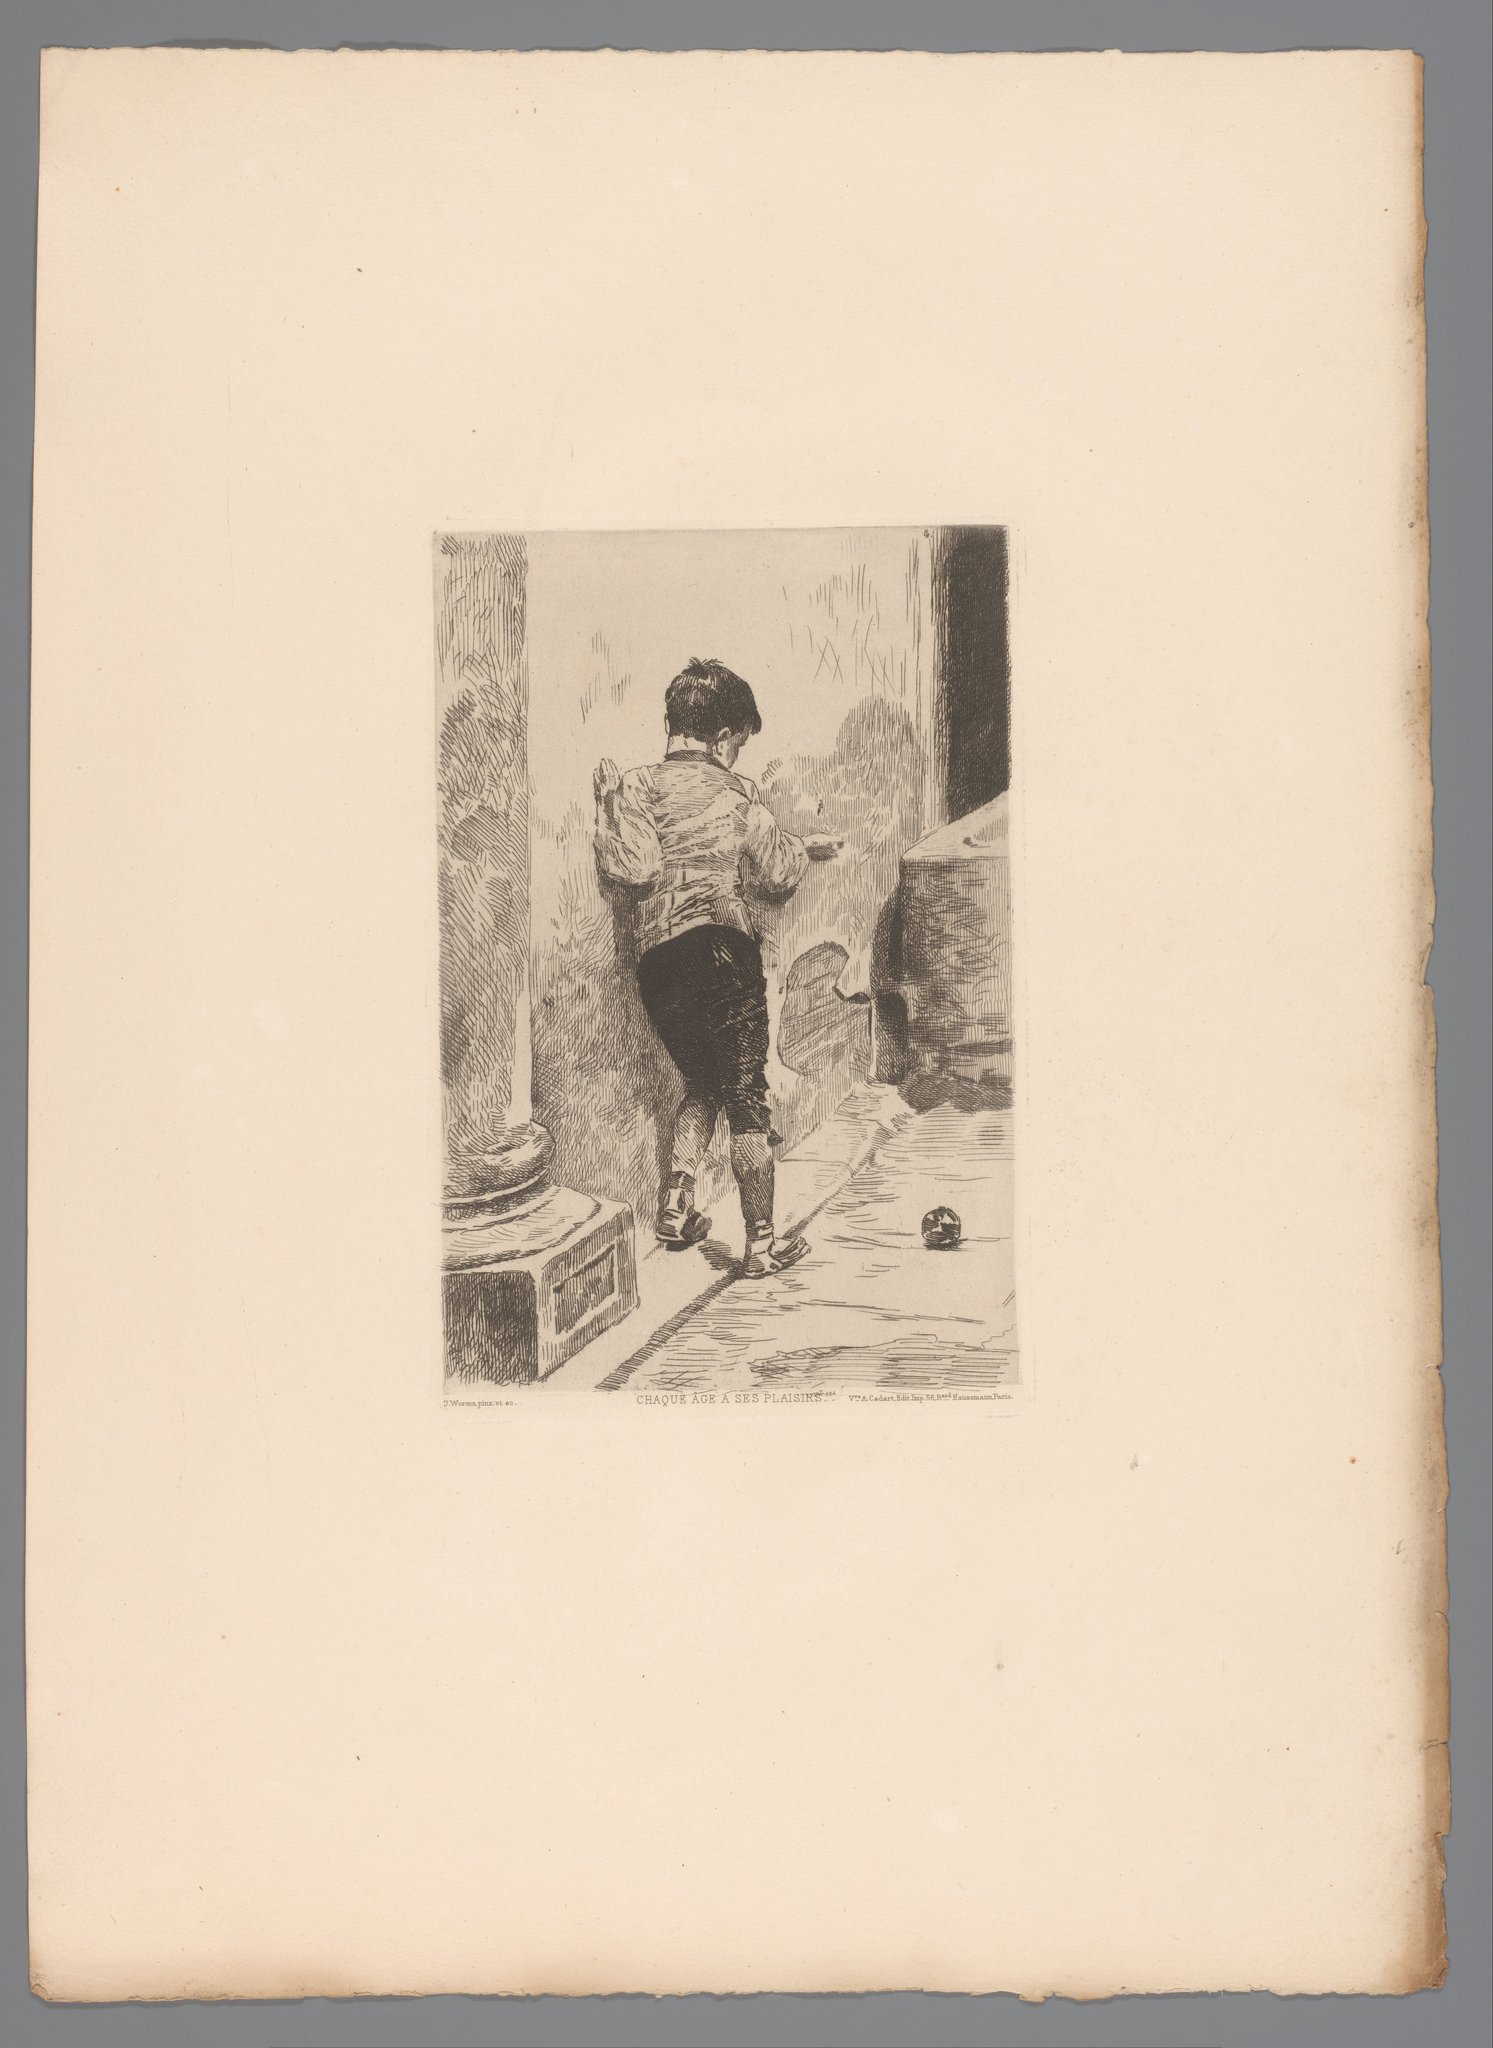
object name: print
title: Spelende jongen bij muur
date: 1879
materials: paper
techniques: drypoint, etching, intaglio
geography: paris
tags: children's games and plays, boy (child between toddler and youth)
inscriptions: collector's mark: Lugt 2228, collector's mark: Lugt 2760, watermark, collector's mark: ‘AFE v S’